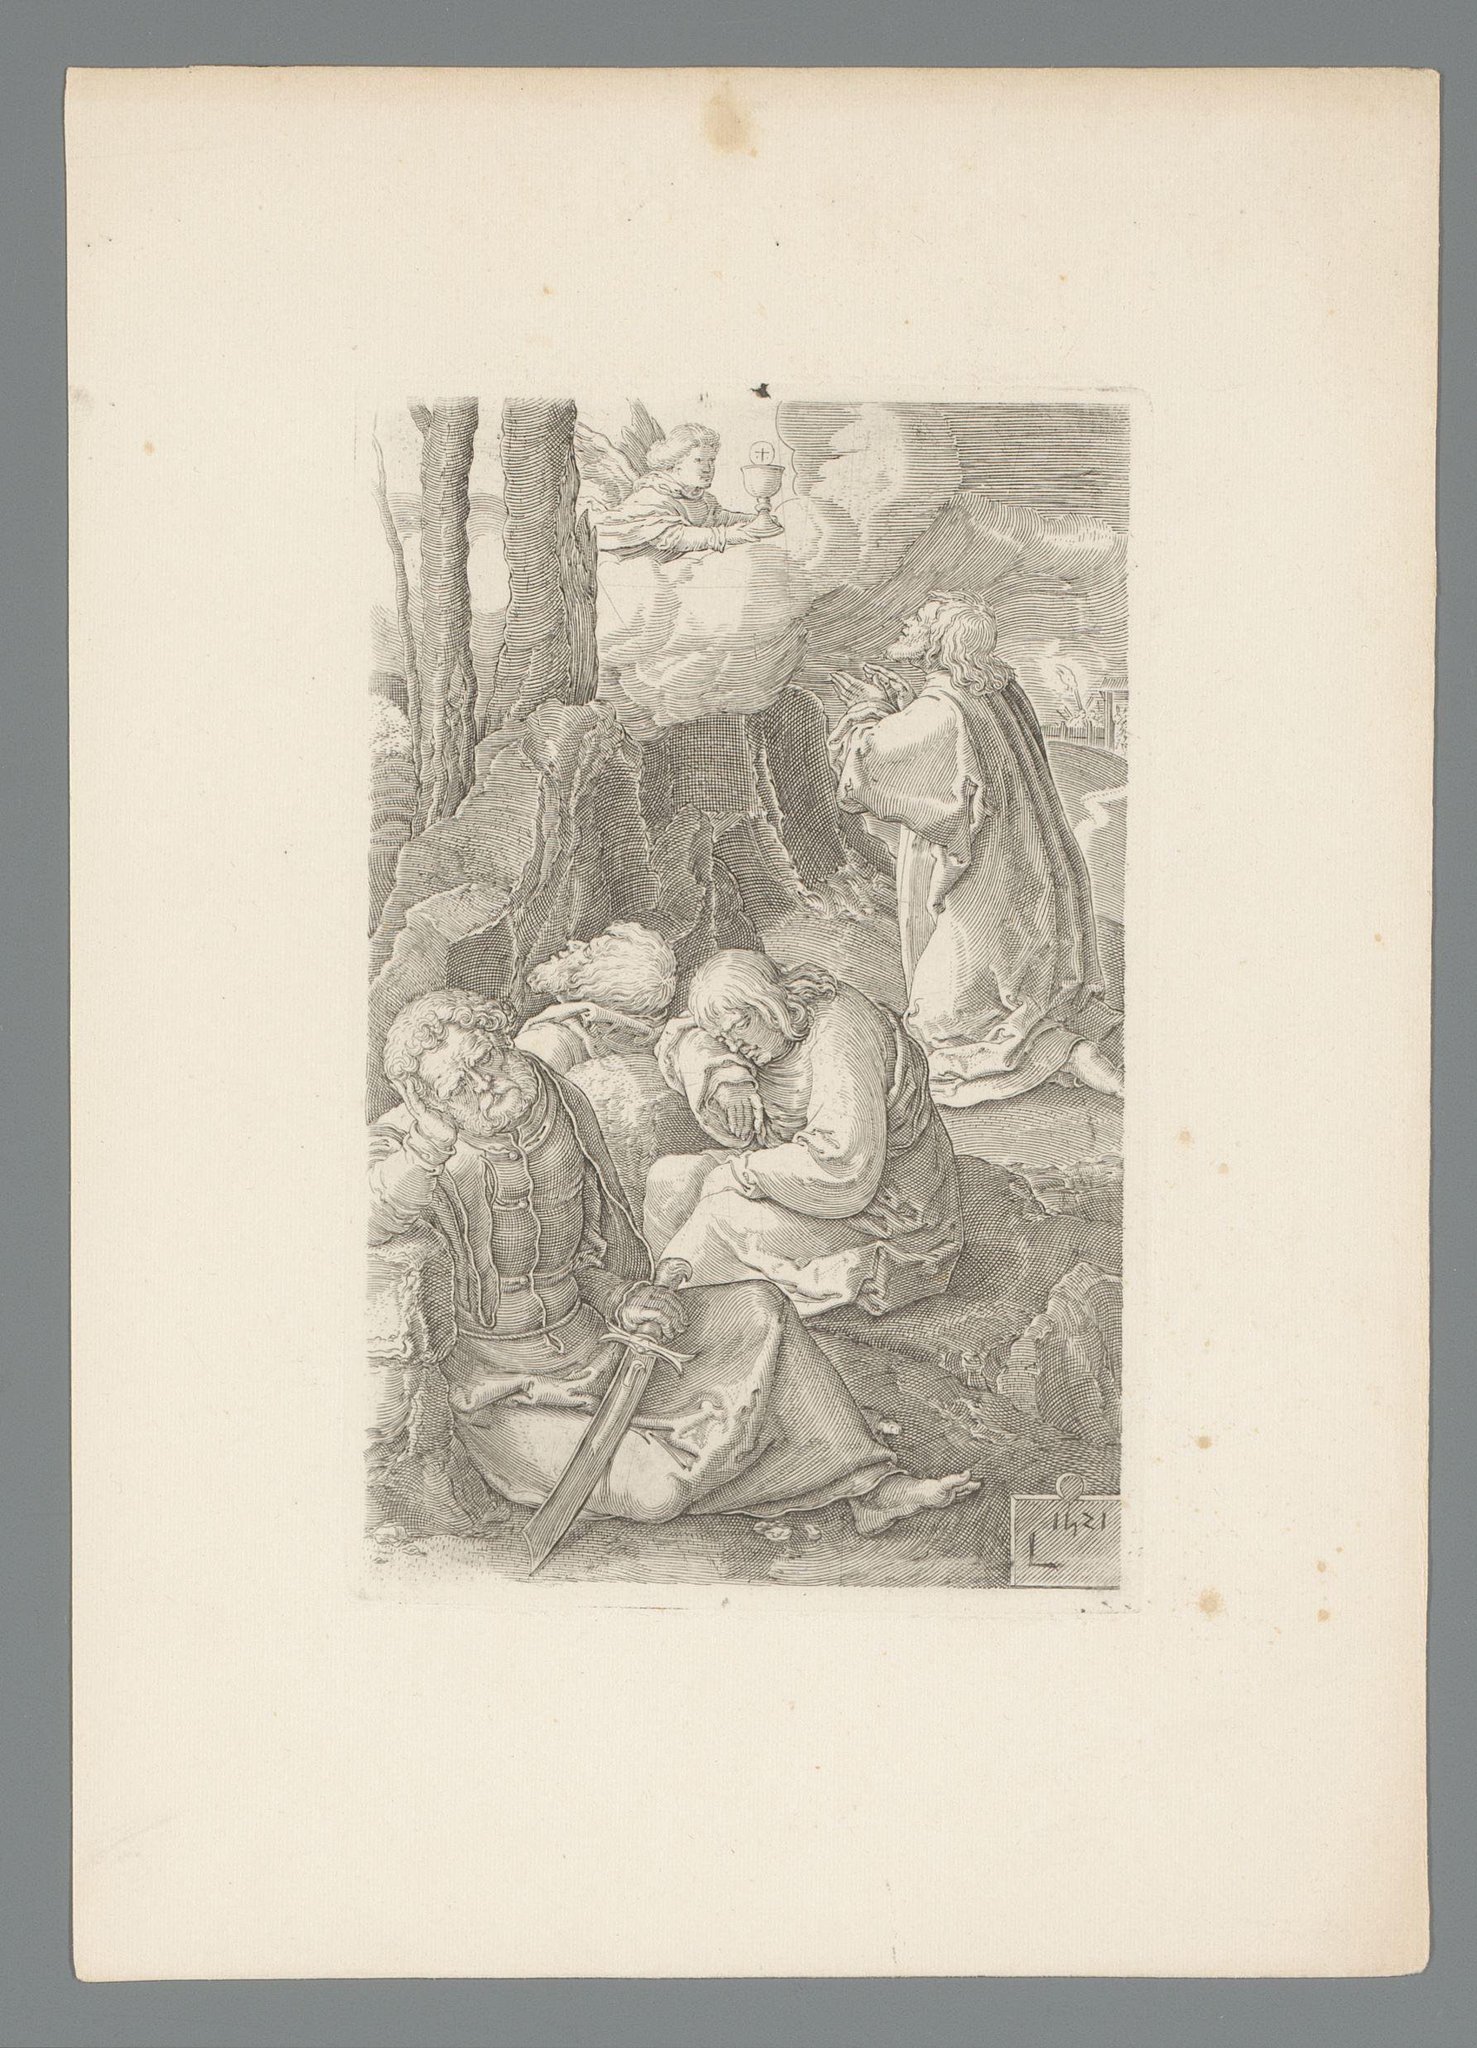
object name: print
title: Die Leiden Christi 14 Blatt. Nach Lucas von Leyden in Kupfer gestochen von J. Müller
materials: paper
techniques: engraving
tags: gethsemane, mount of olives, 'oelberg' (matthew 26:36-56; mark 14:32-52; luke 22:39-53; john 18:1-12)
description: Maakt deel uit van een serie die in de negentiende eeuw is herdrukt met de titel: Die Leiden Christi 14 Blatt. Nach Lucas von Leyden in Kupfer gestochen von J. Müller.